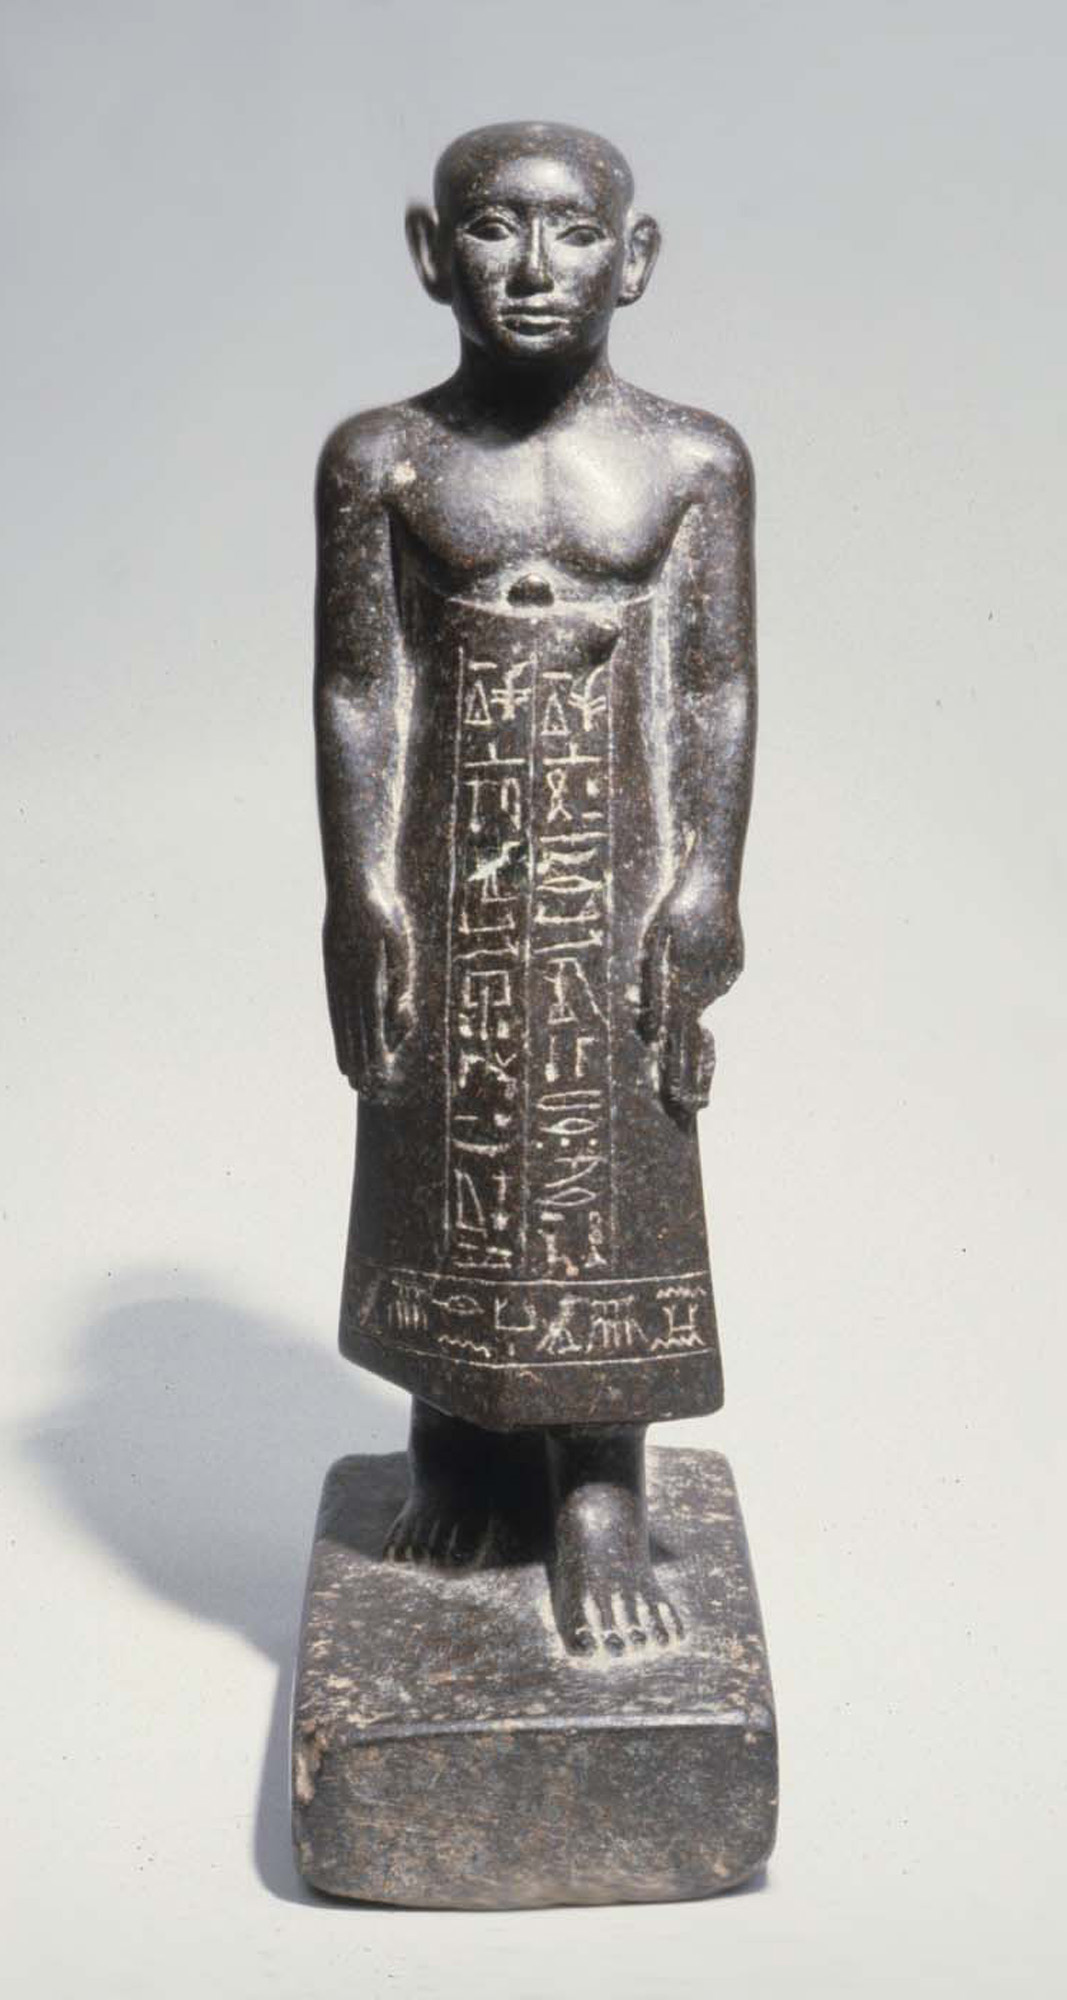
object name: statue, khentika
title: Statue of Khentika with Shaved Head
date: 1802-1640 BCE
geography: memphite region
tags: men,hieroglyphs